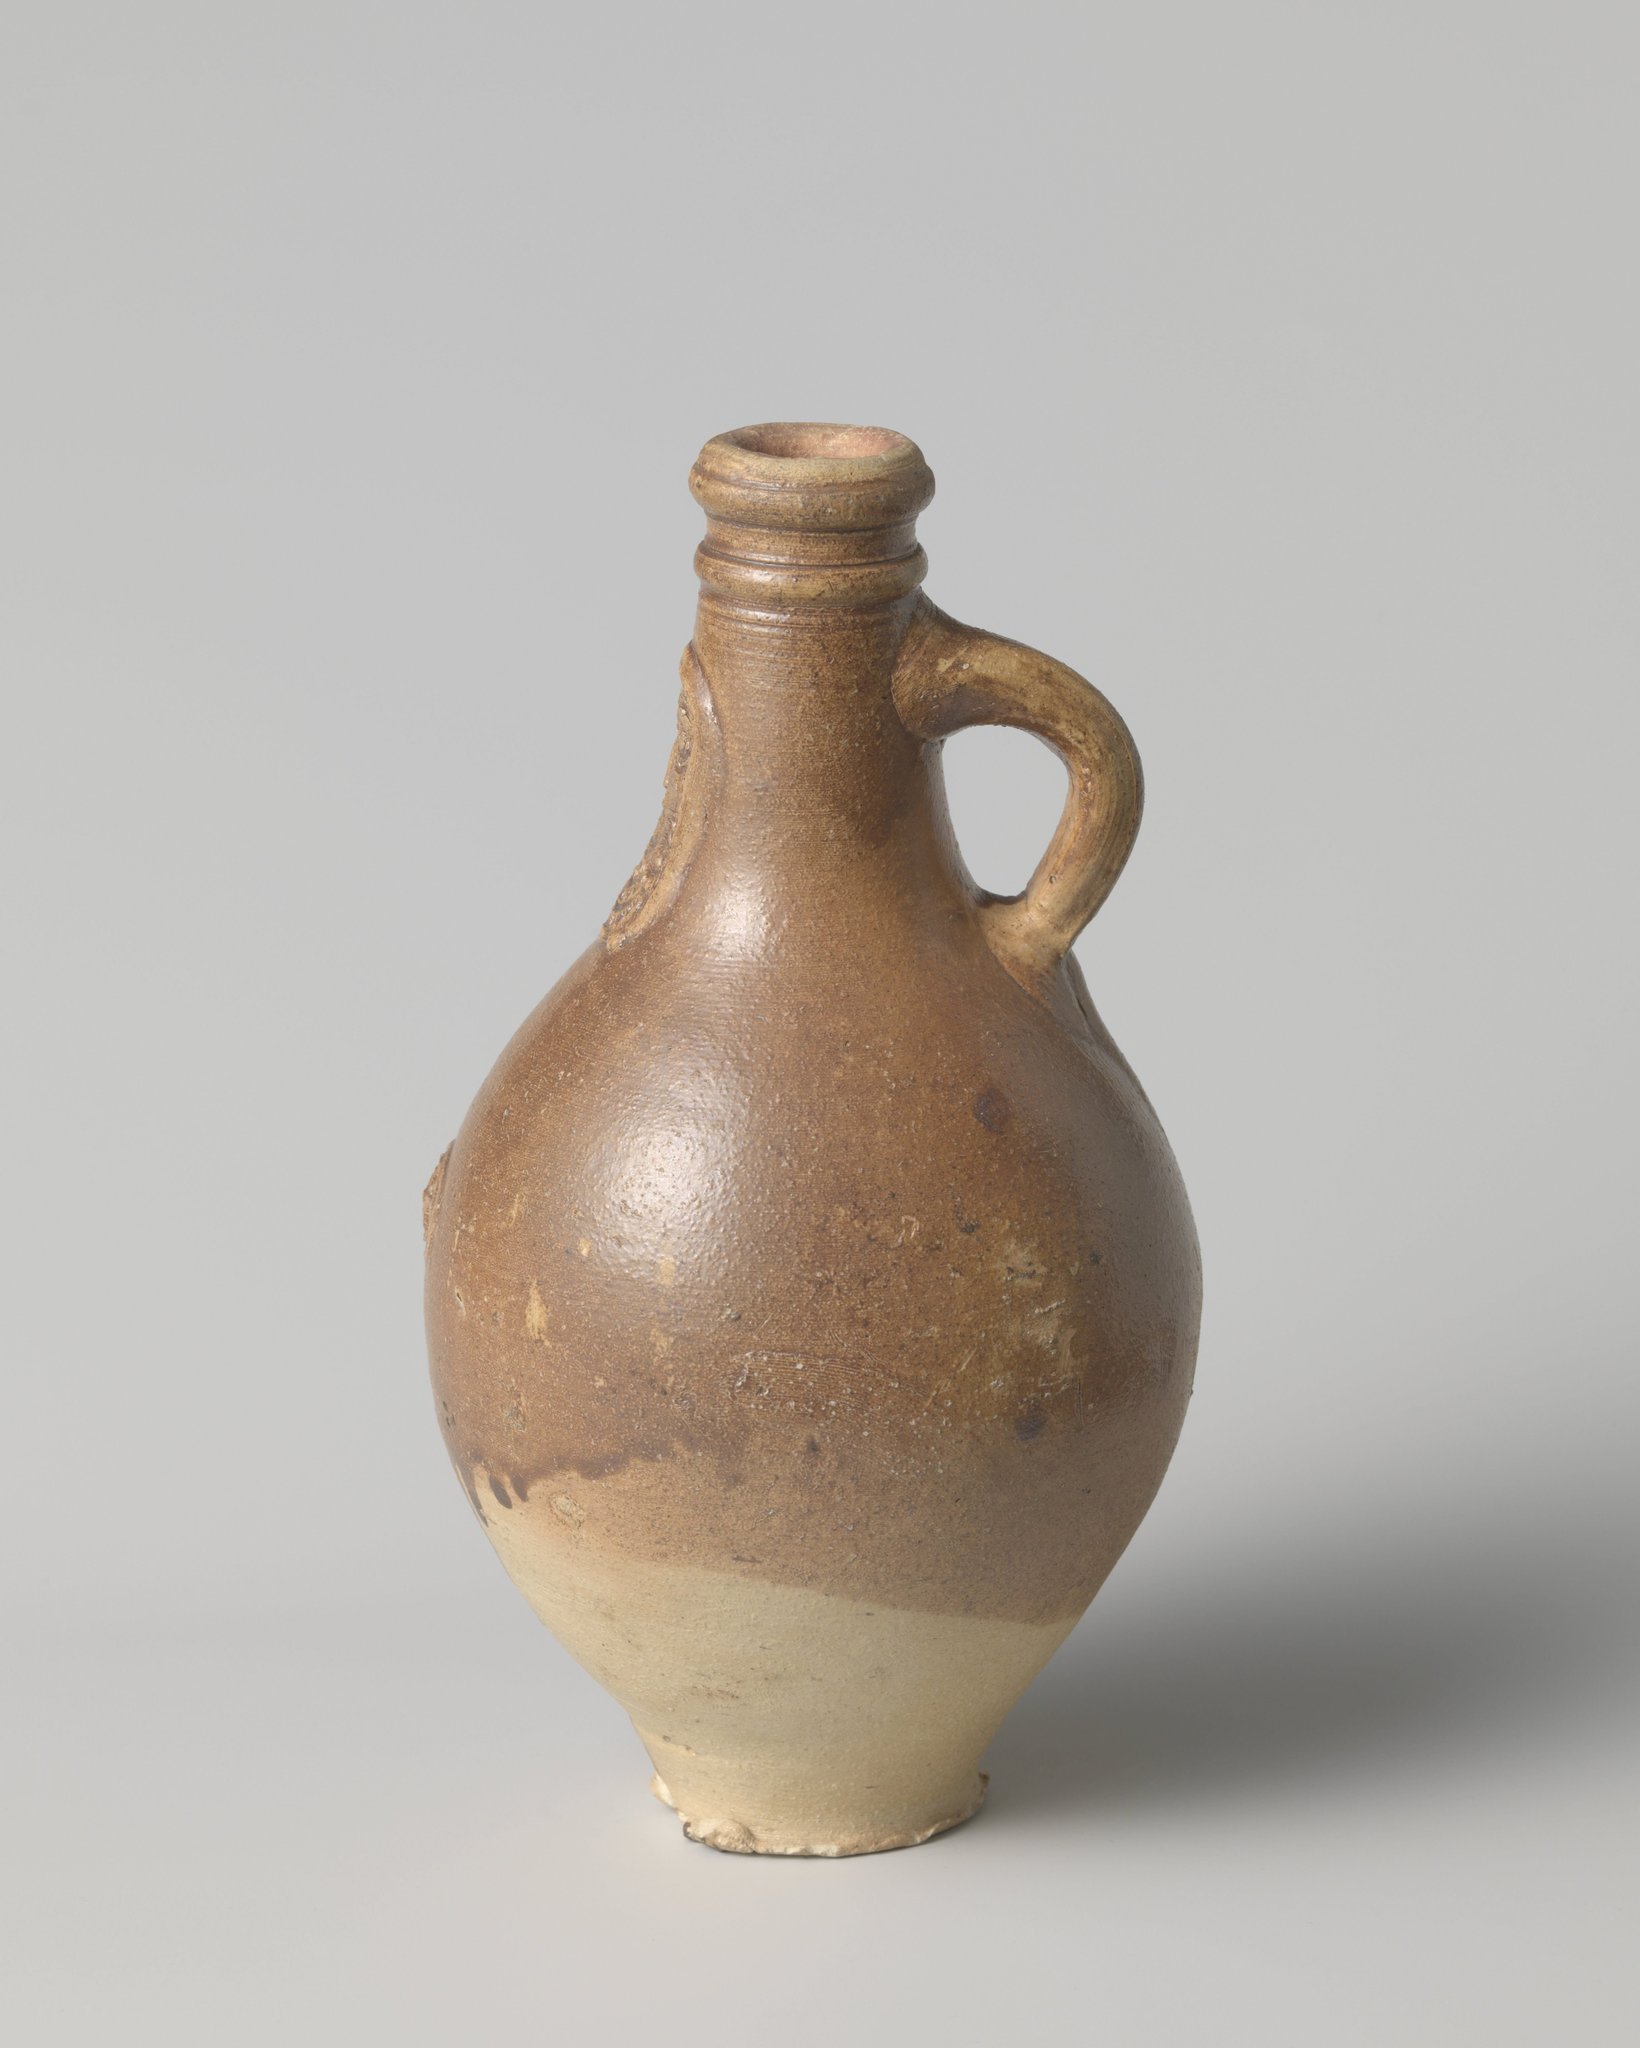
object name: jug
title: Jug (Bartmann jug) with a roundel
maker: Anonymous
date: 1650-1799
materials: engobe, glaze, stoneware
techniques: firing, forming, relief, turning, vitrification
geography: frechen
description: Kruik (baardmankruik) van steengoed op standvlak met een eivormig lichaam en smalle nek. Het C-vormige oor is bevestigd aan de nek en de schouder. Profielen op de nek. Bedekt met een bruine engobe. Op de buik in reliëf een gedrukt en opgelegd medaillon met een rozet. Op de nek, doorlopend op de schouder, een baardman. Frechen.